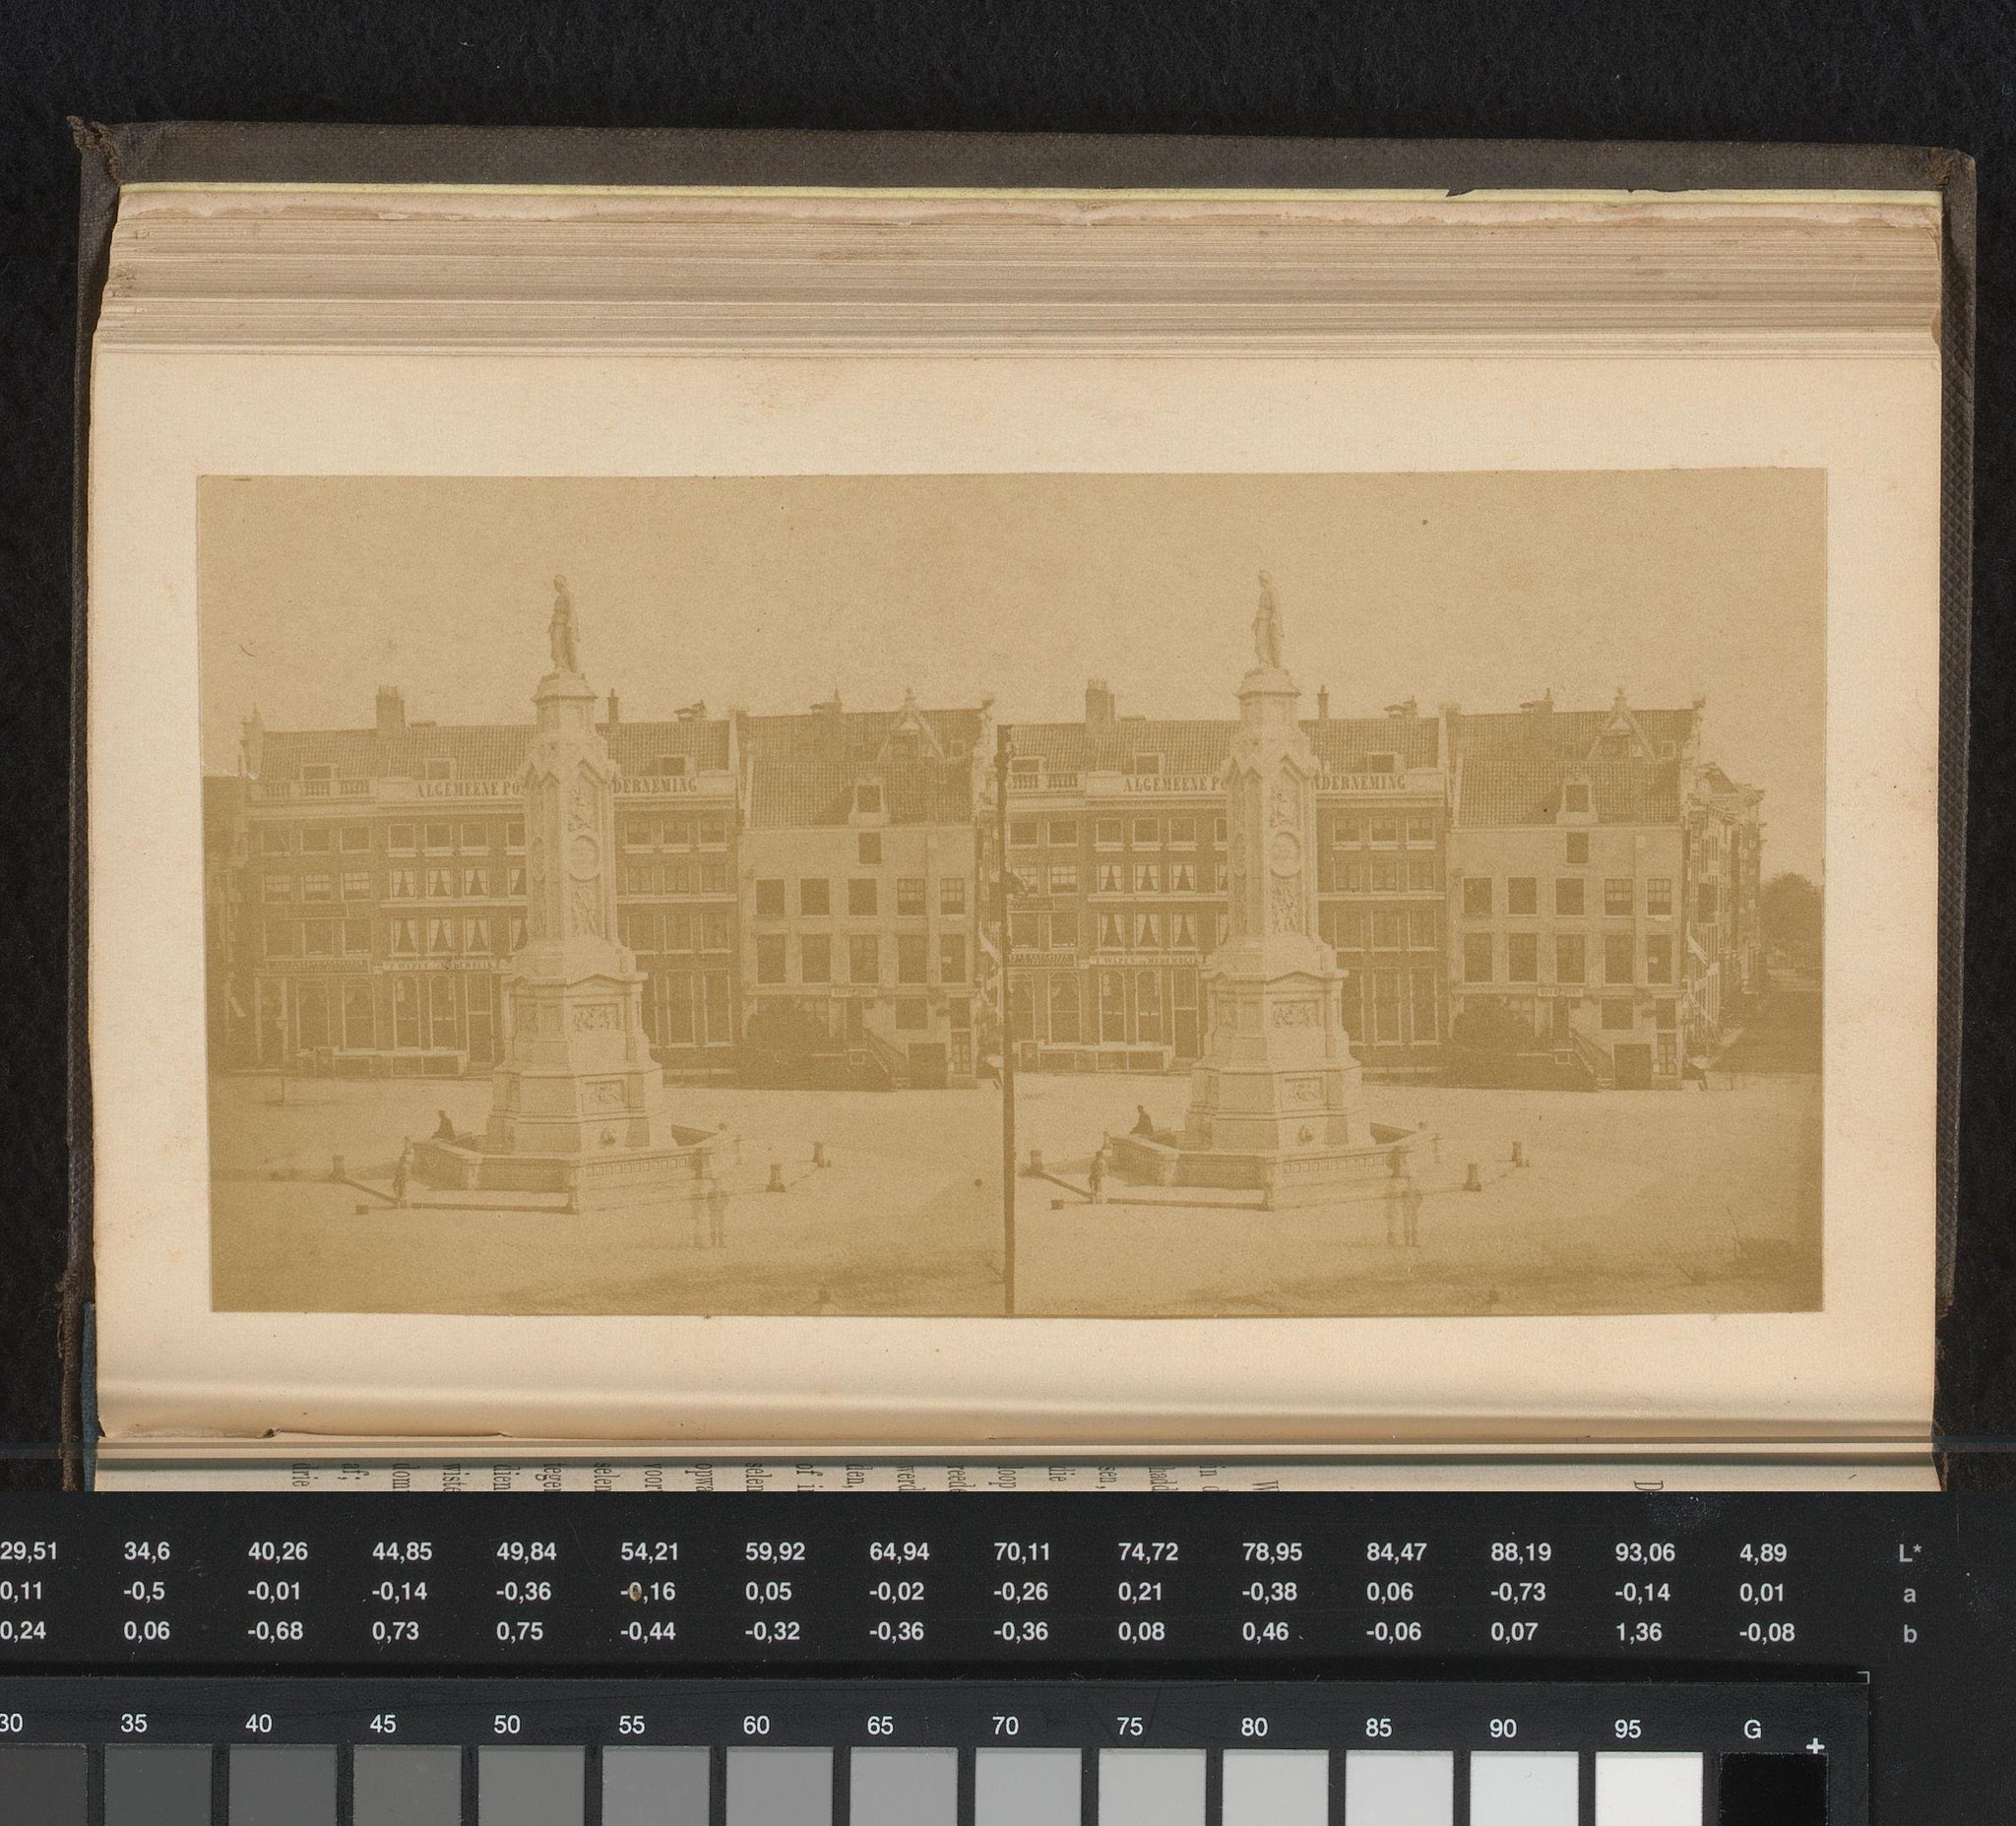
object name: page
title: Monument De Eendracht, ofwel 'Naatje op de Dam', Amsterdam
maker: Anonymous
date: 1860-1865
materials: paper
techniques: albumen print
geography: amsterdam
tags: square, place, circus, etc., monument, statue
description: Stereofoto op ongenummerde pagina tegenover pagina 1.